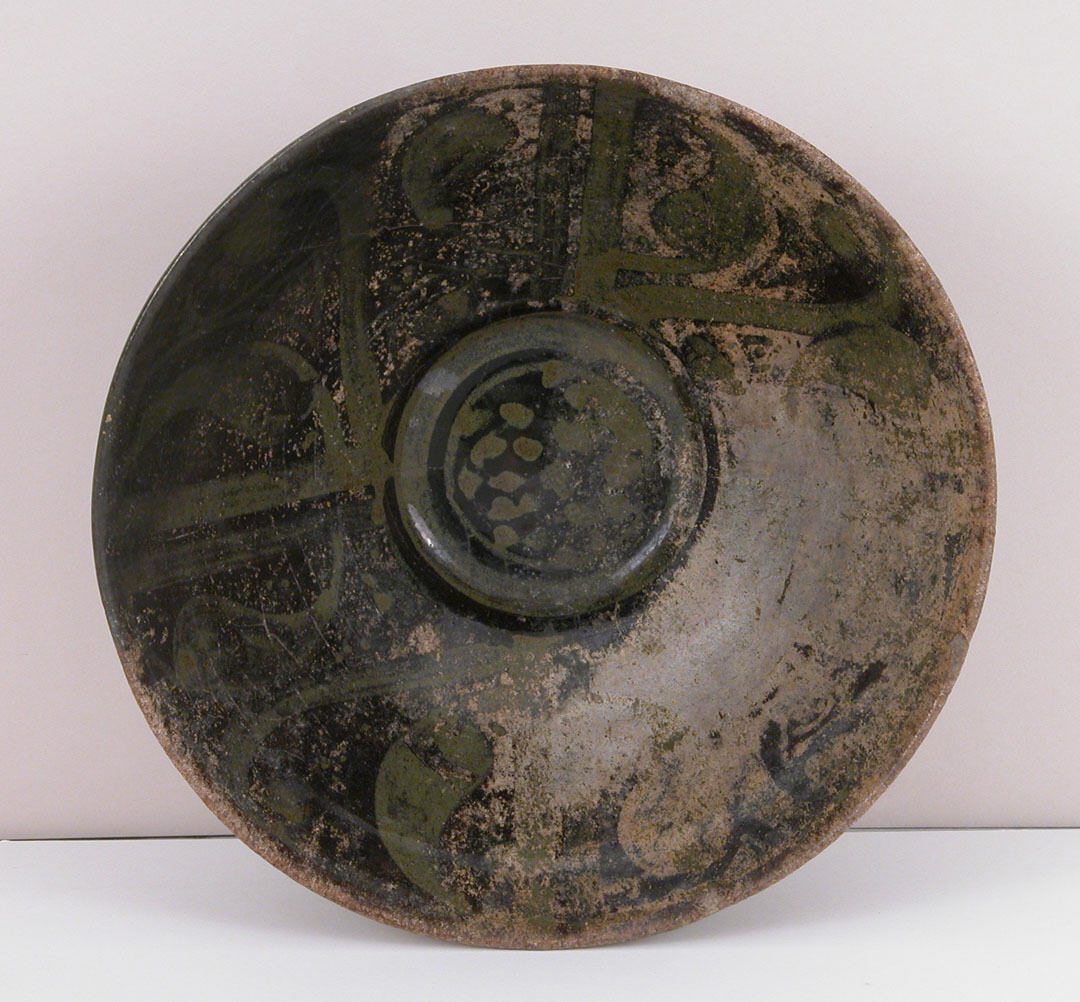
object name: bowl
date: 1134-1166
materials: glaze, stonepaste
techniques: luster painting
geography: syria